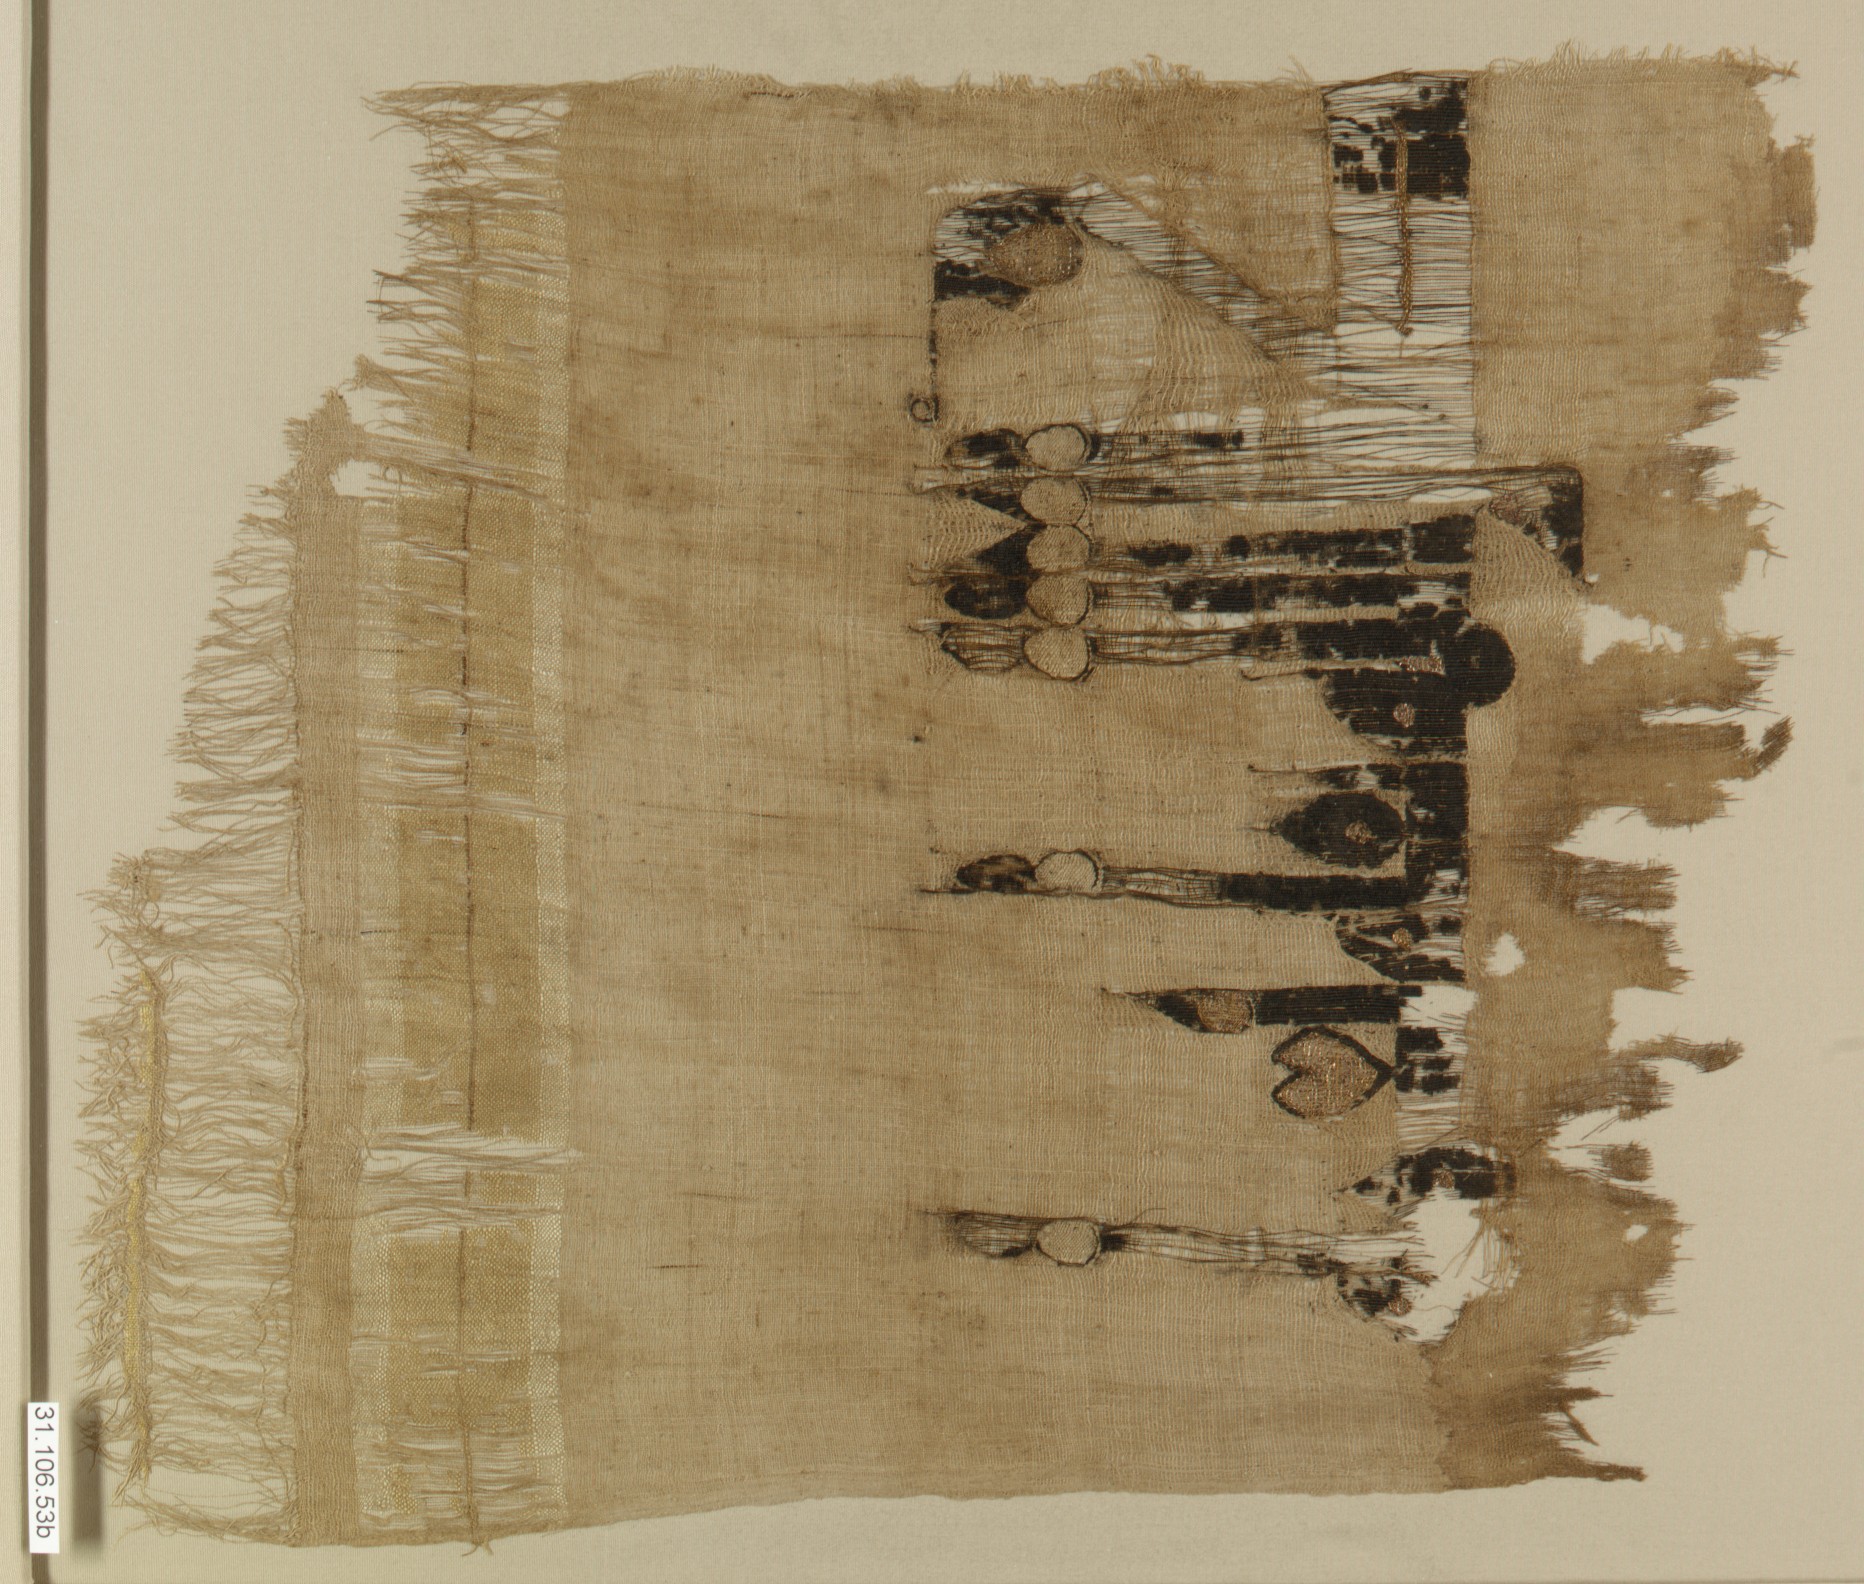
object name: textile fragment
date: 946-974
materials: linen, silk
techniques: weave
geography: egypt